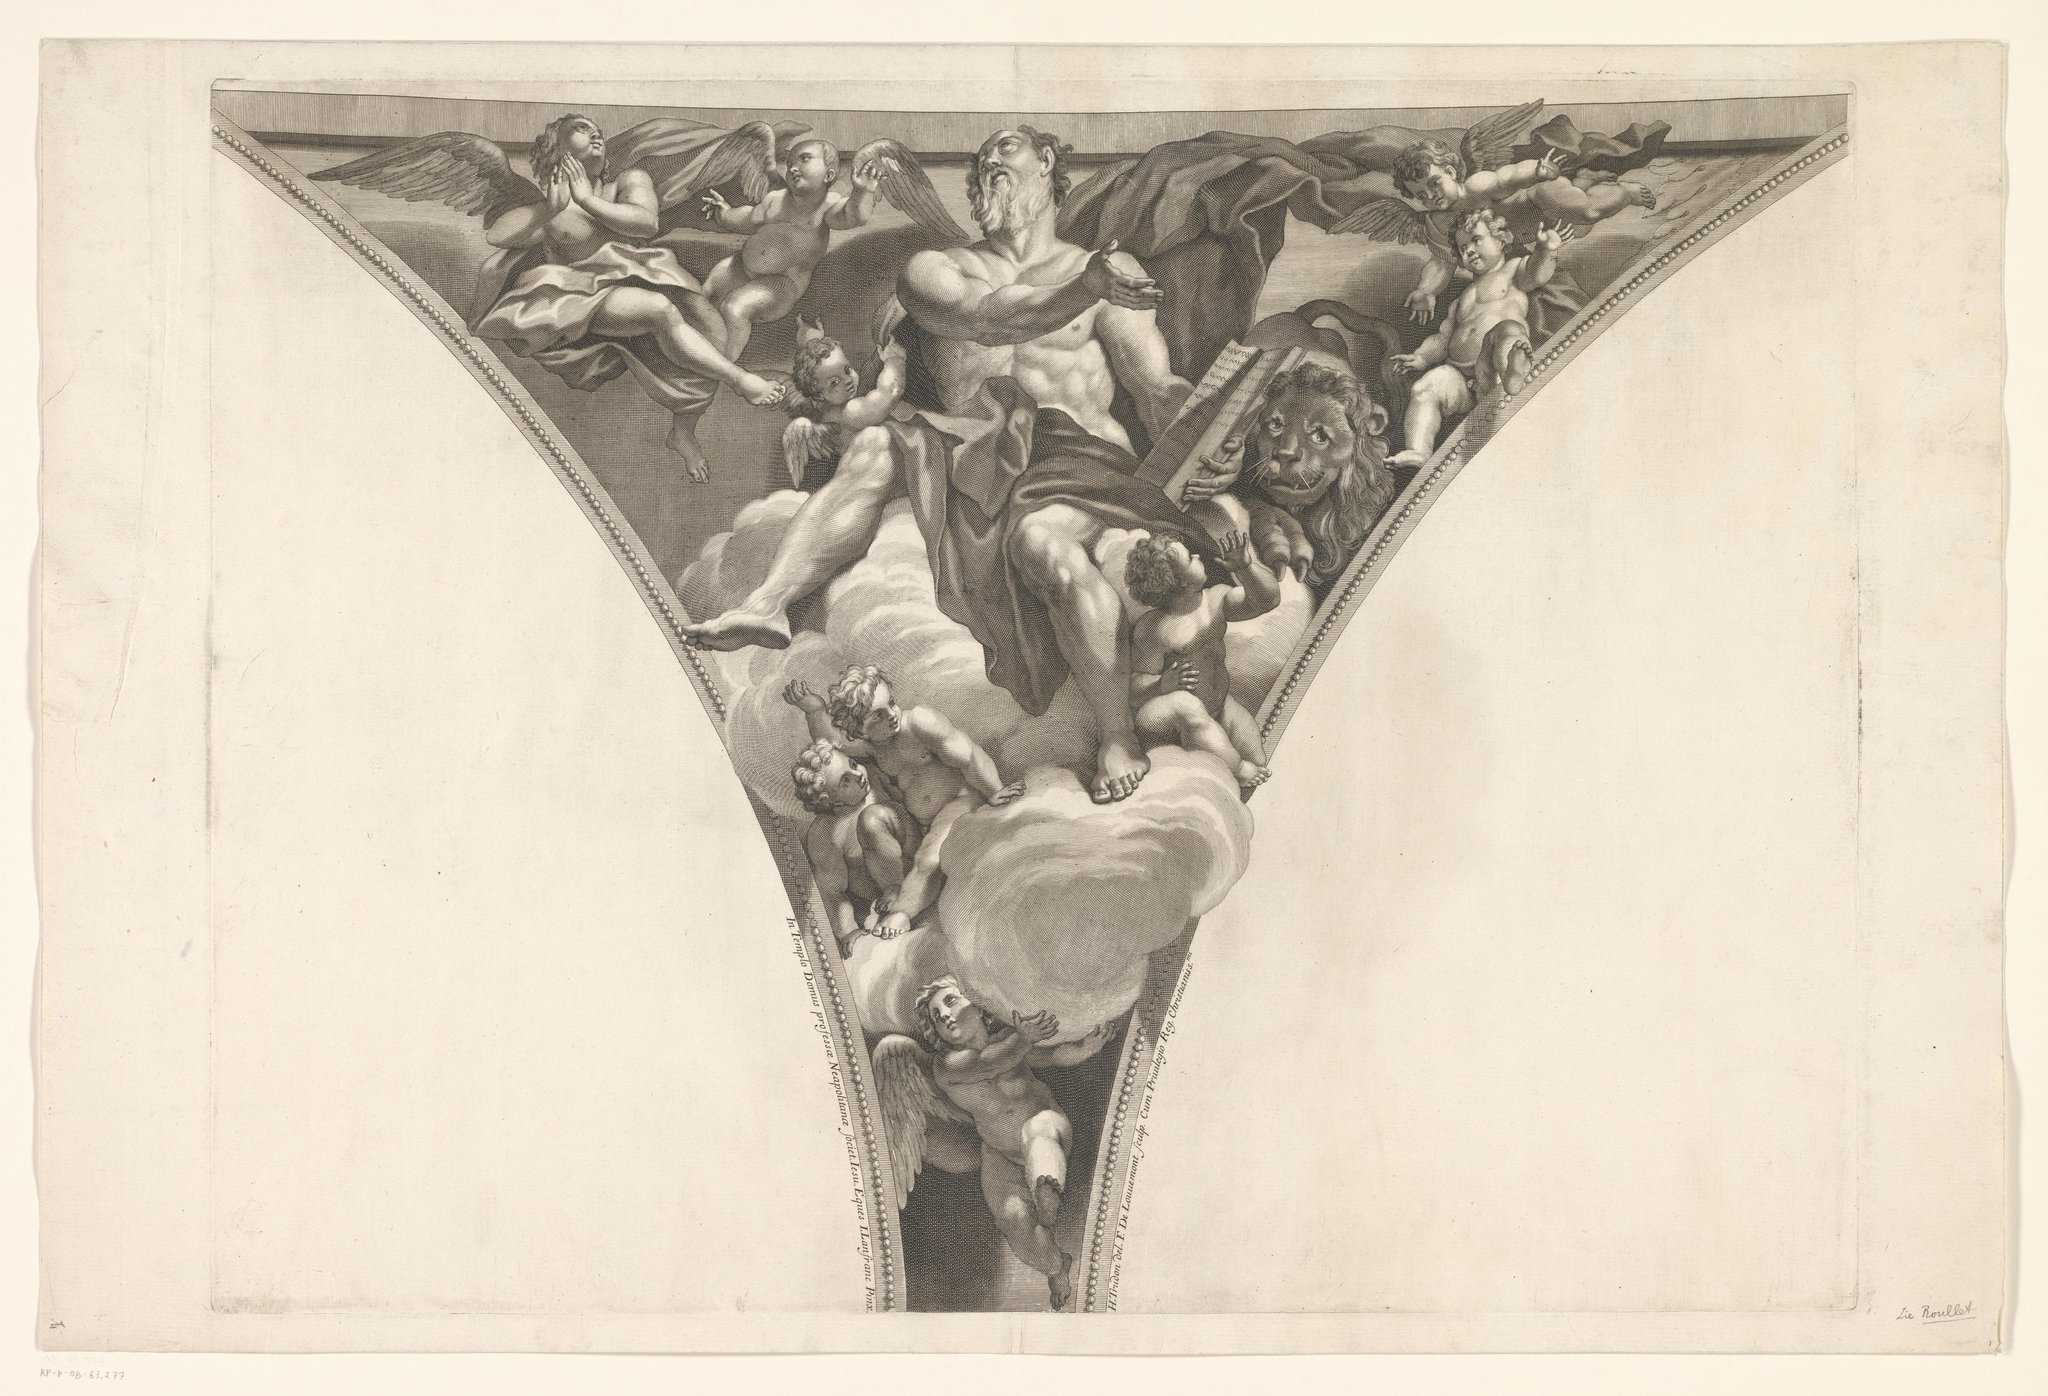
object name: print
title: H. Marcus omgeven door leeuw en engelen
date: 1658-1748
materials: paper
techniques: engraving, etching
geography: france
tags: lion (possibly with book) ~ symbol of st. mark, mark (marcus) the evangelist, and bishop of alexandria; possible attributes: book, (winged) lion, pen and inkhorn, scroll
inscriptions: collector's mark: Lugt 240, watermark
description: Marcus op een wolk zittend, omgeven door engelen. Naast hem zijn attribuut de leeuw. Zwikvulling.